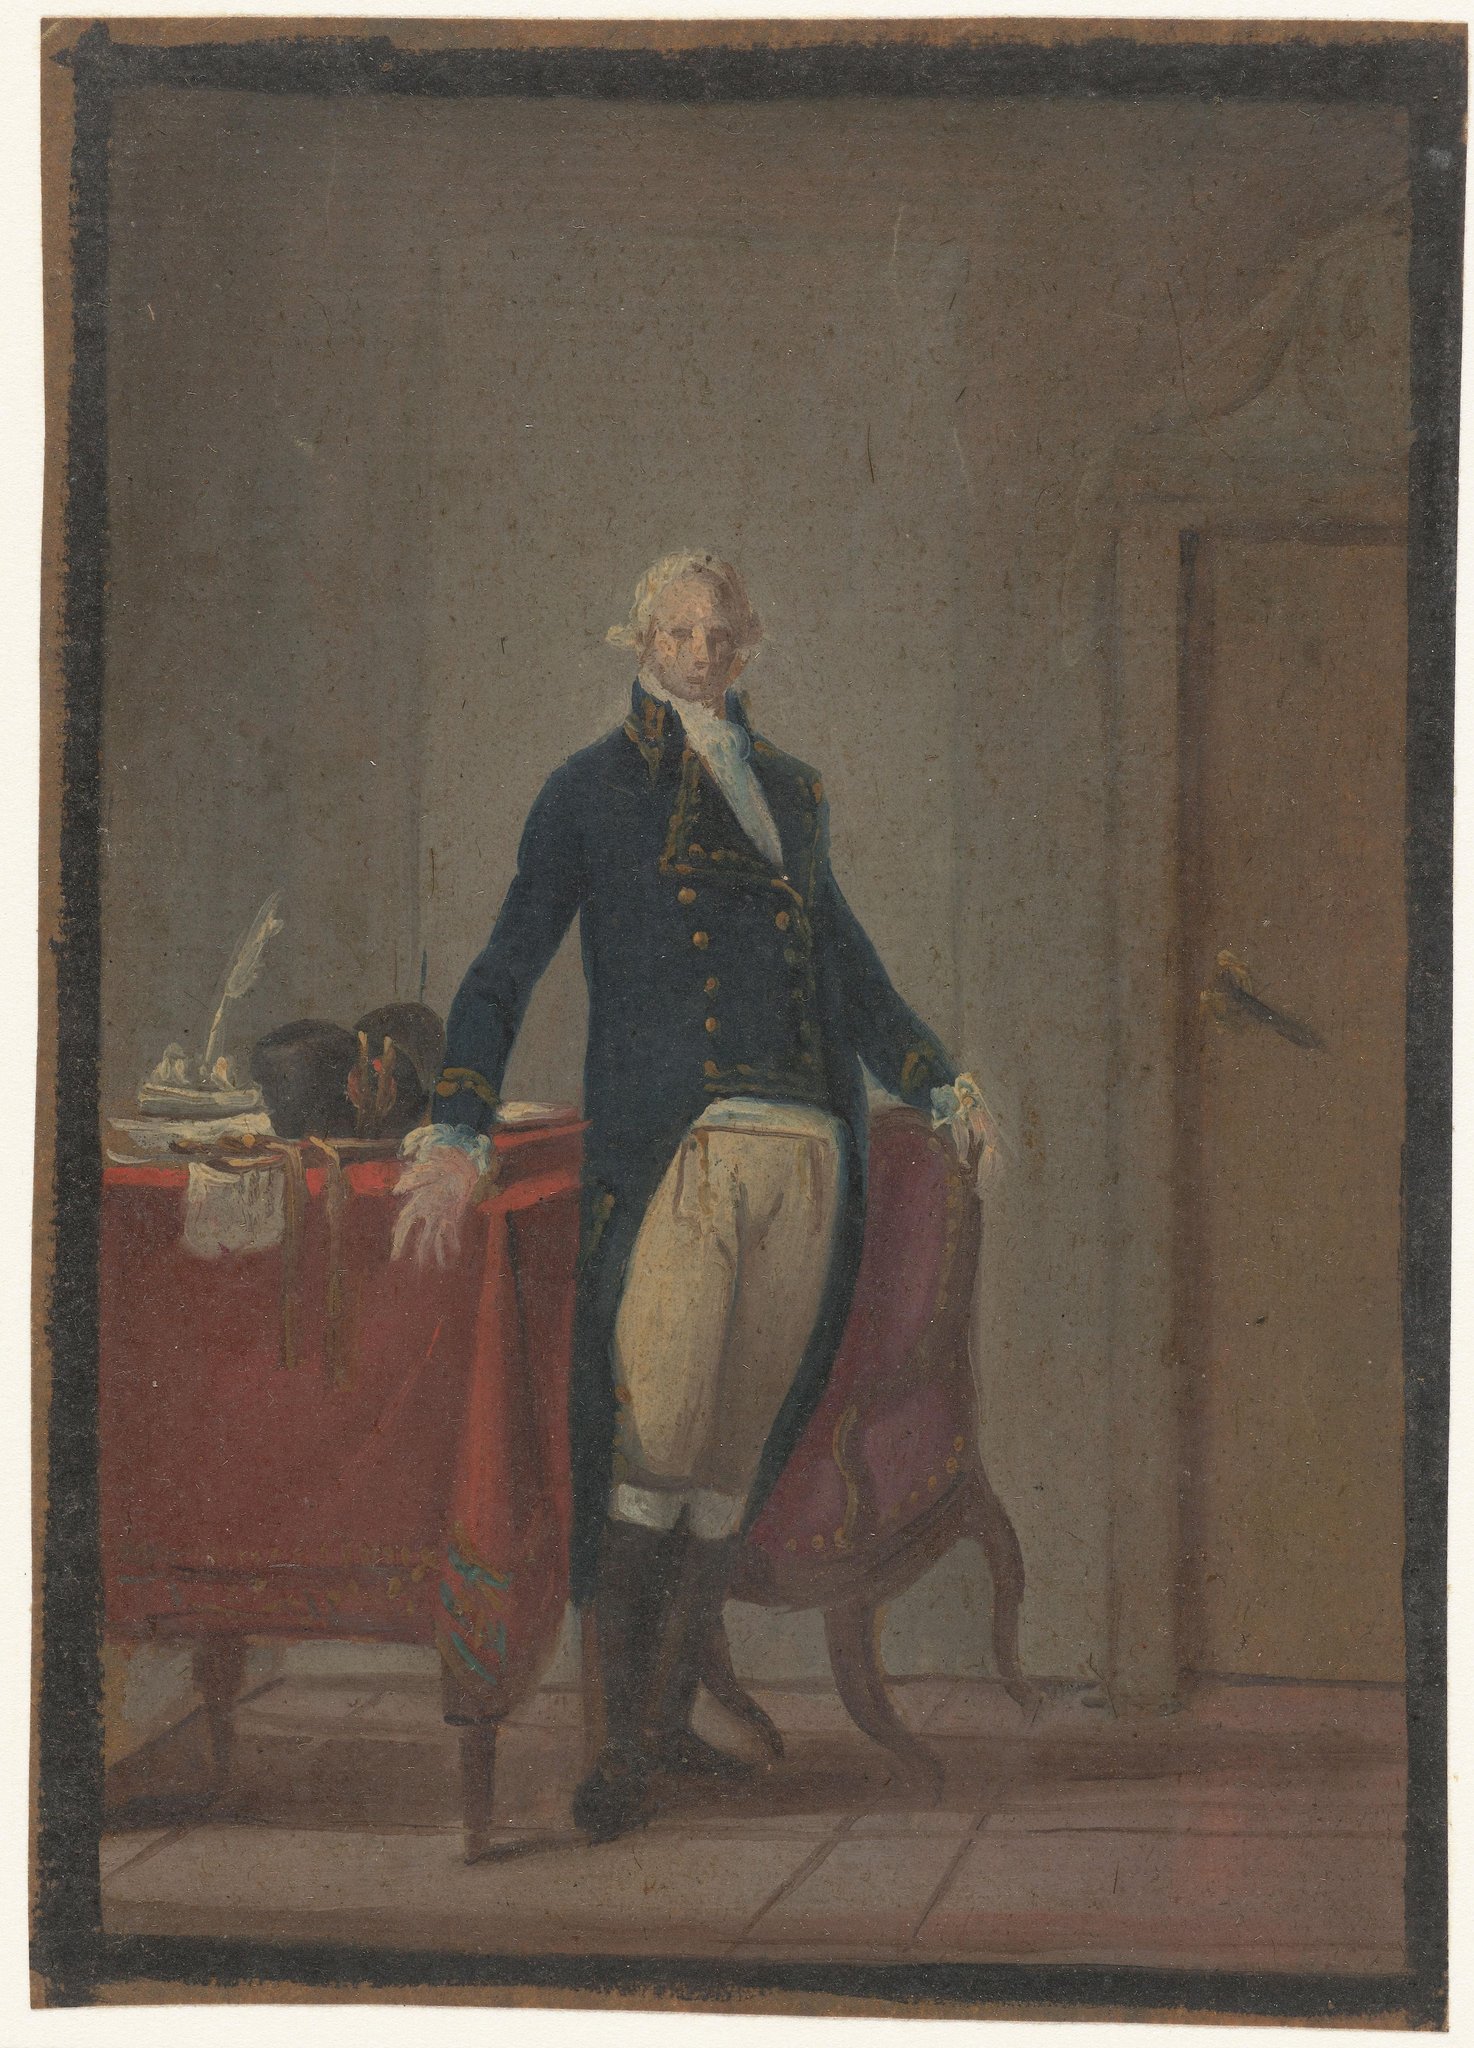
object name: drawing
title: Staande man voor zijn schrijftafel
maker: Anonymous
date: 1700-1800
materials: oil, paper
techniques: brush